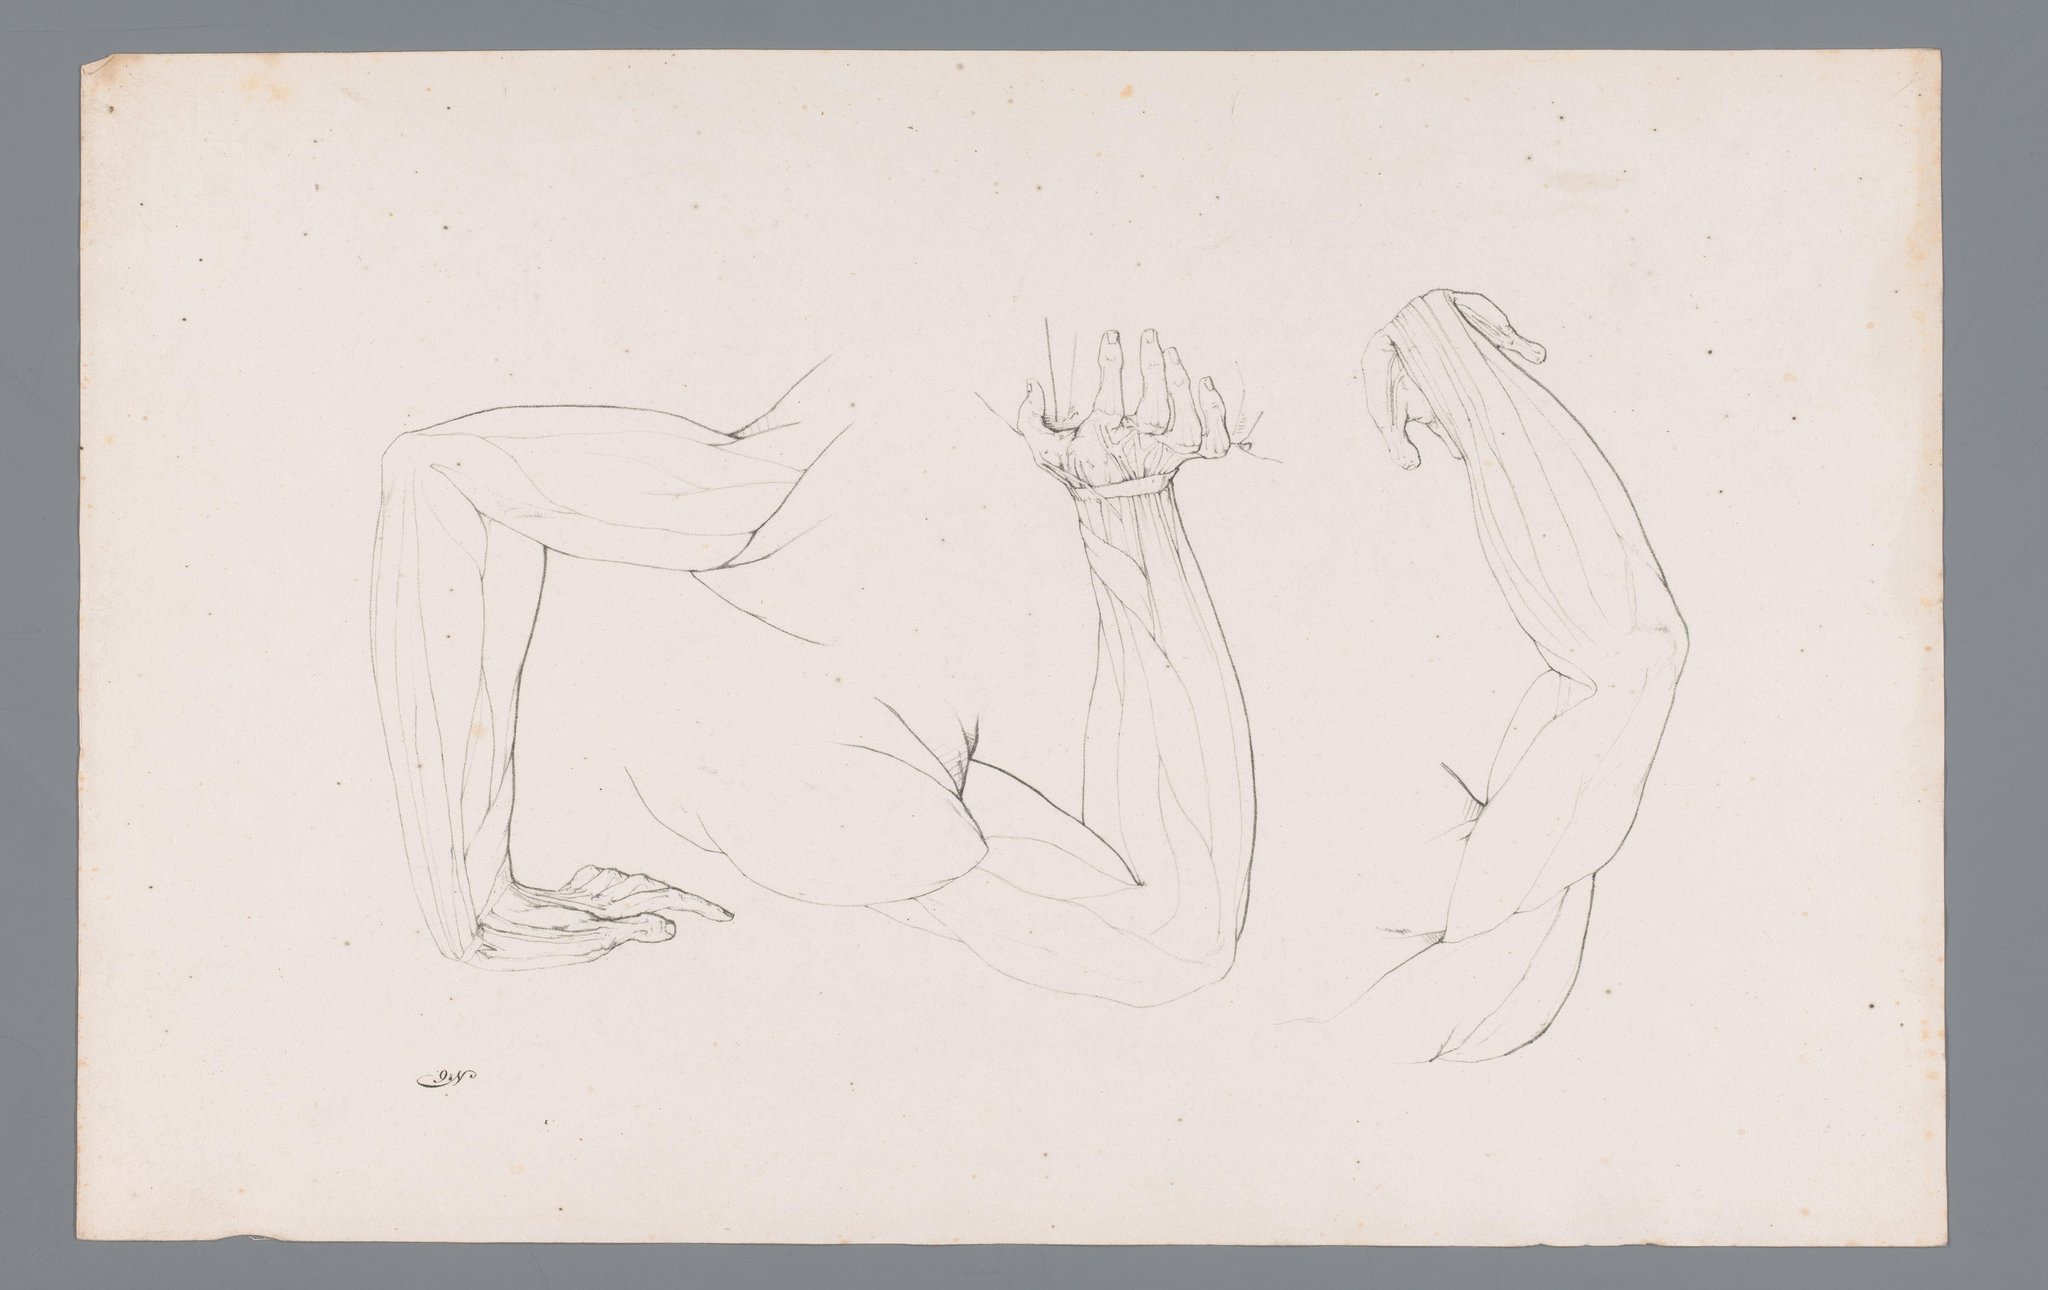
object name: print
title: Anatomie-studien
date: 1828-1830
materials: paper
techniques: lithograph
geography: amsterdam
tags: arms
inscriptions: collector's mark: Lugt 2760, collector's mark: Lugt 2228, watermark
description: Onderdeel van een omslag met een serie van twaalf anatomische voorstellingen.